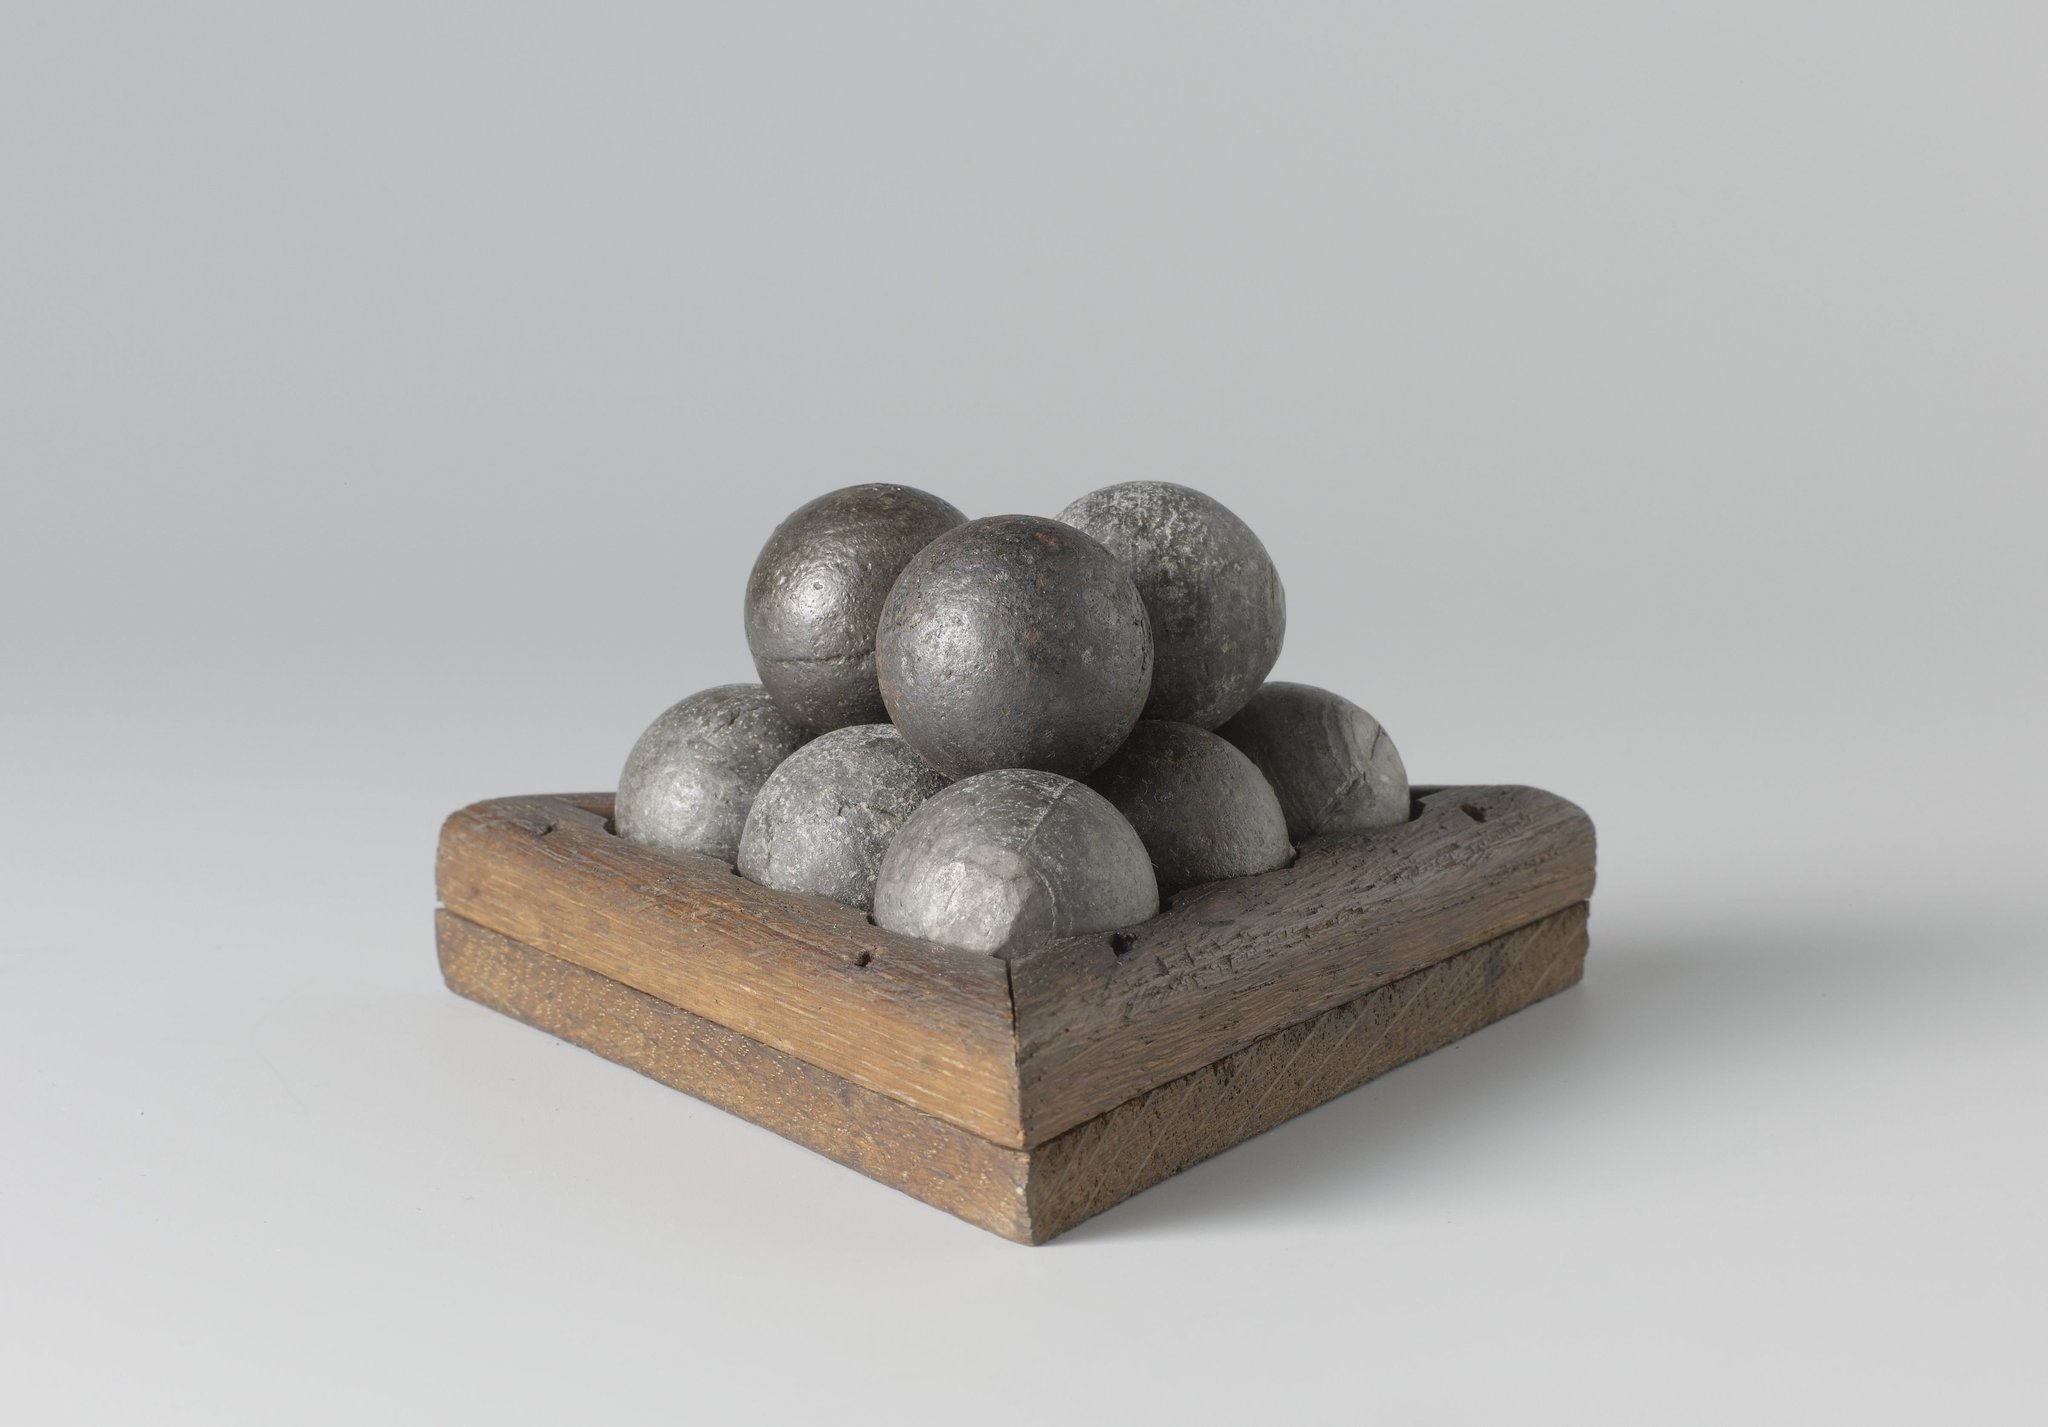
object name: scale model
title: Model van een driehoekige kogelstapel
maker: Anonymous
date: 1699-1900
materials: iron, wood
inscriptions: number: ‘ok.a. 15516’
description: Model van een driehoekige kogelstapel van 10 kogels op een houten houder. Een kogel ontbreekt.